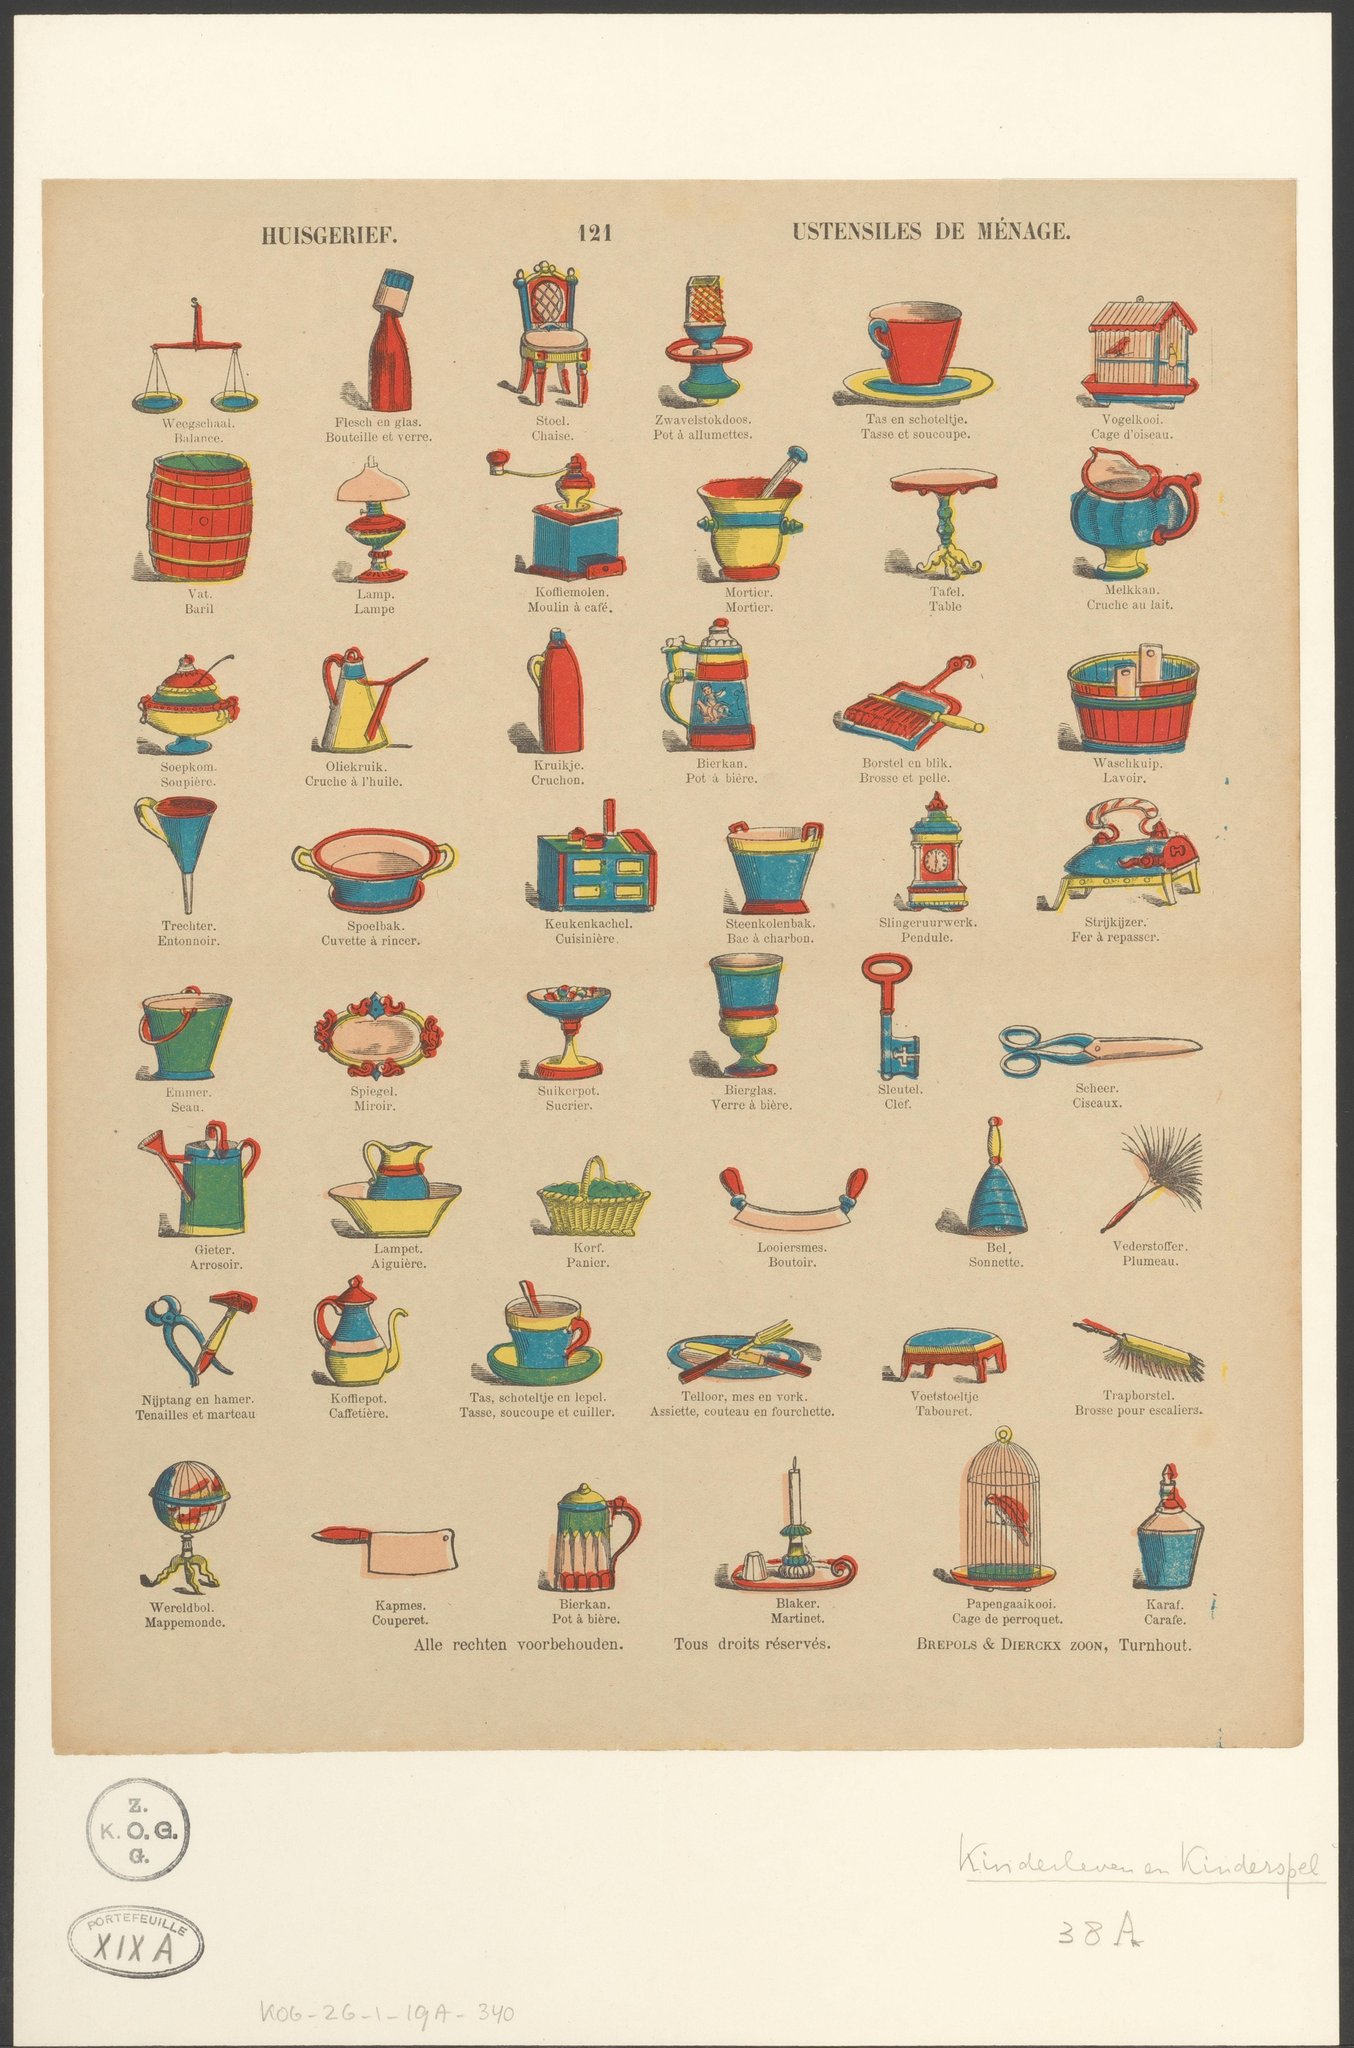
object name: print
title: Huisraad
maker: Anonymous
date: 1833-1911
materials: paper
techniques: lithograph, letterpress printing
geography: turnhout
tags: animals, characters (human types), (household) utensils and implements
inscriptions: collector's mark: Lugt 1641, stamp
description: Blad met 48 voorstellingen van verschillende huishoudelijke voorwerpen. Onder elke voorstelling een onderschrift in het Nederlands en in het Frans. Genummerd midden boven: 121. Onderwerpsrubrieken binnen de Atlas Zeden en Gewoonten: Zeden en Gewoonten in Engeren Zin, Des menschen beging, midden en einde, Kinderleven – Kinderspel en Kinderprenten.